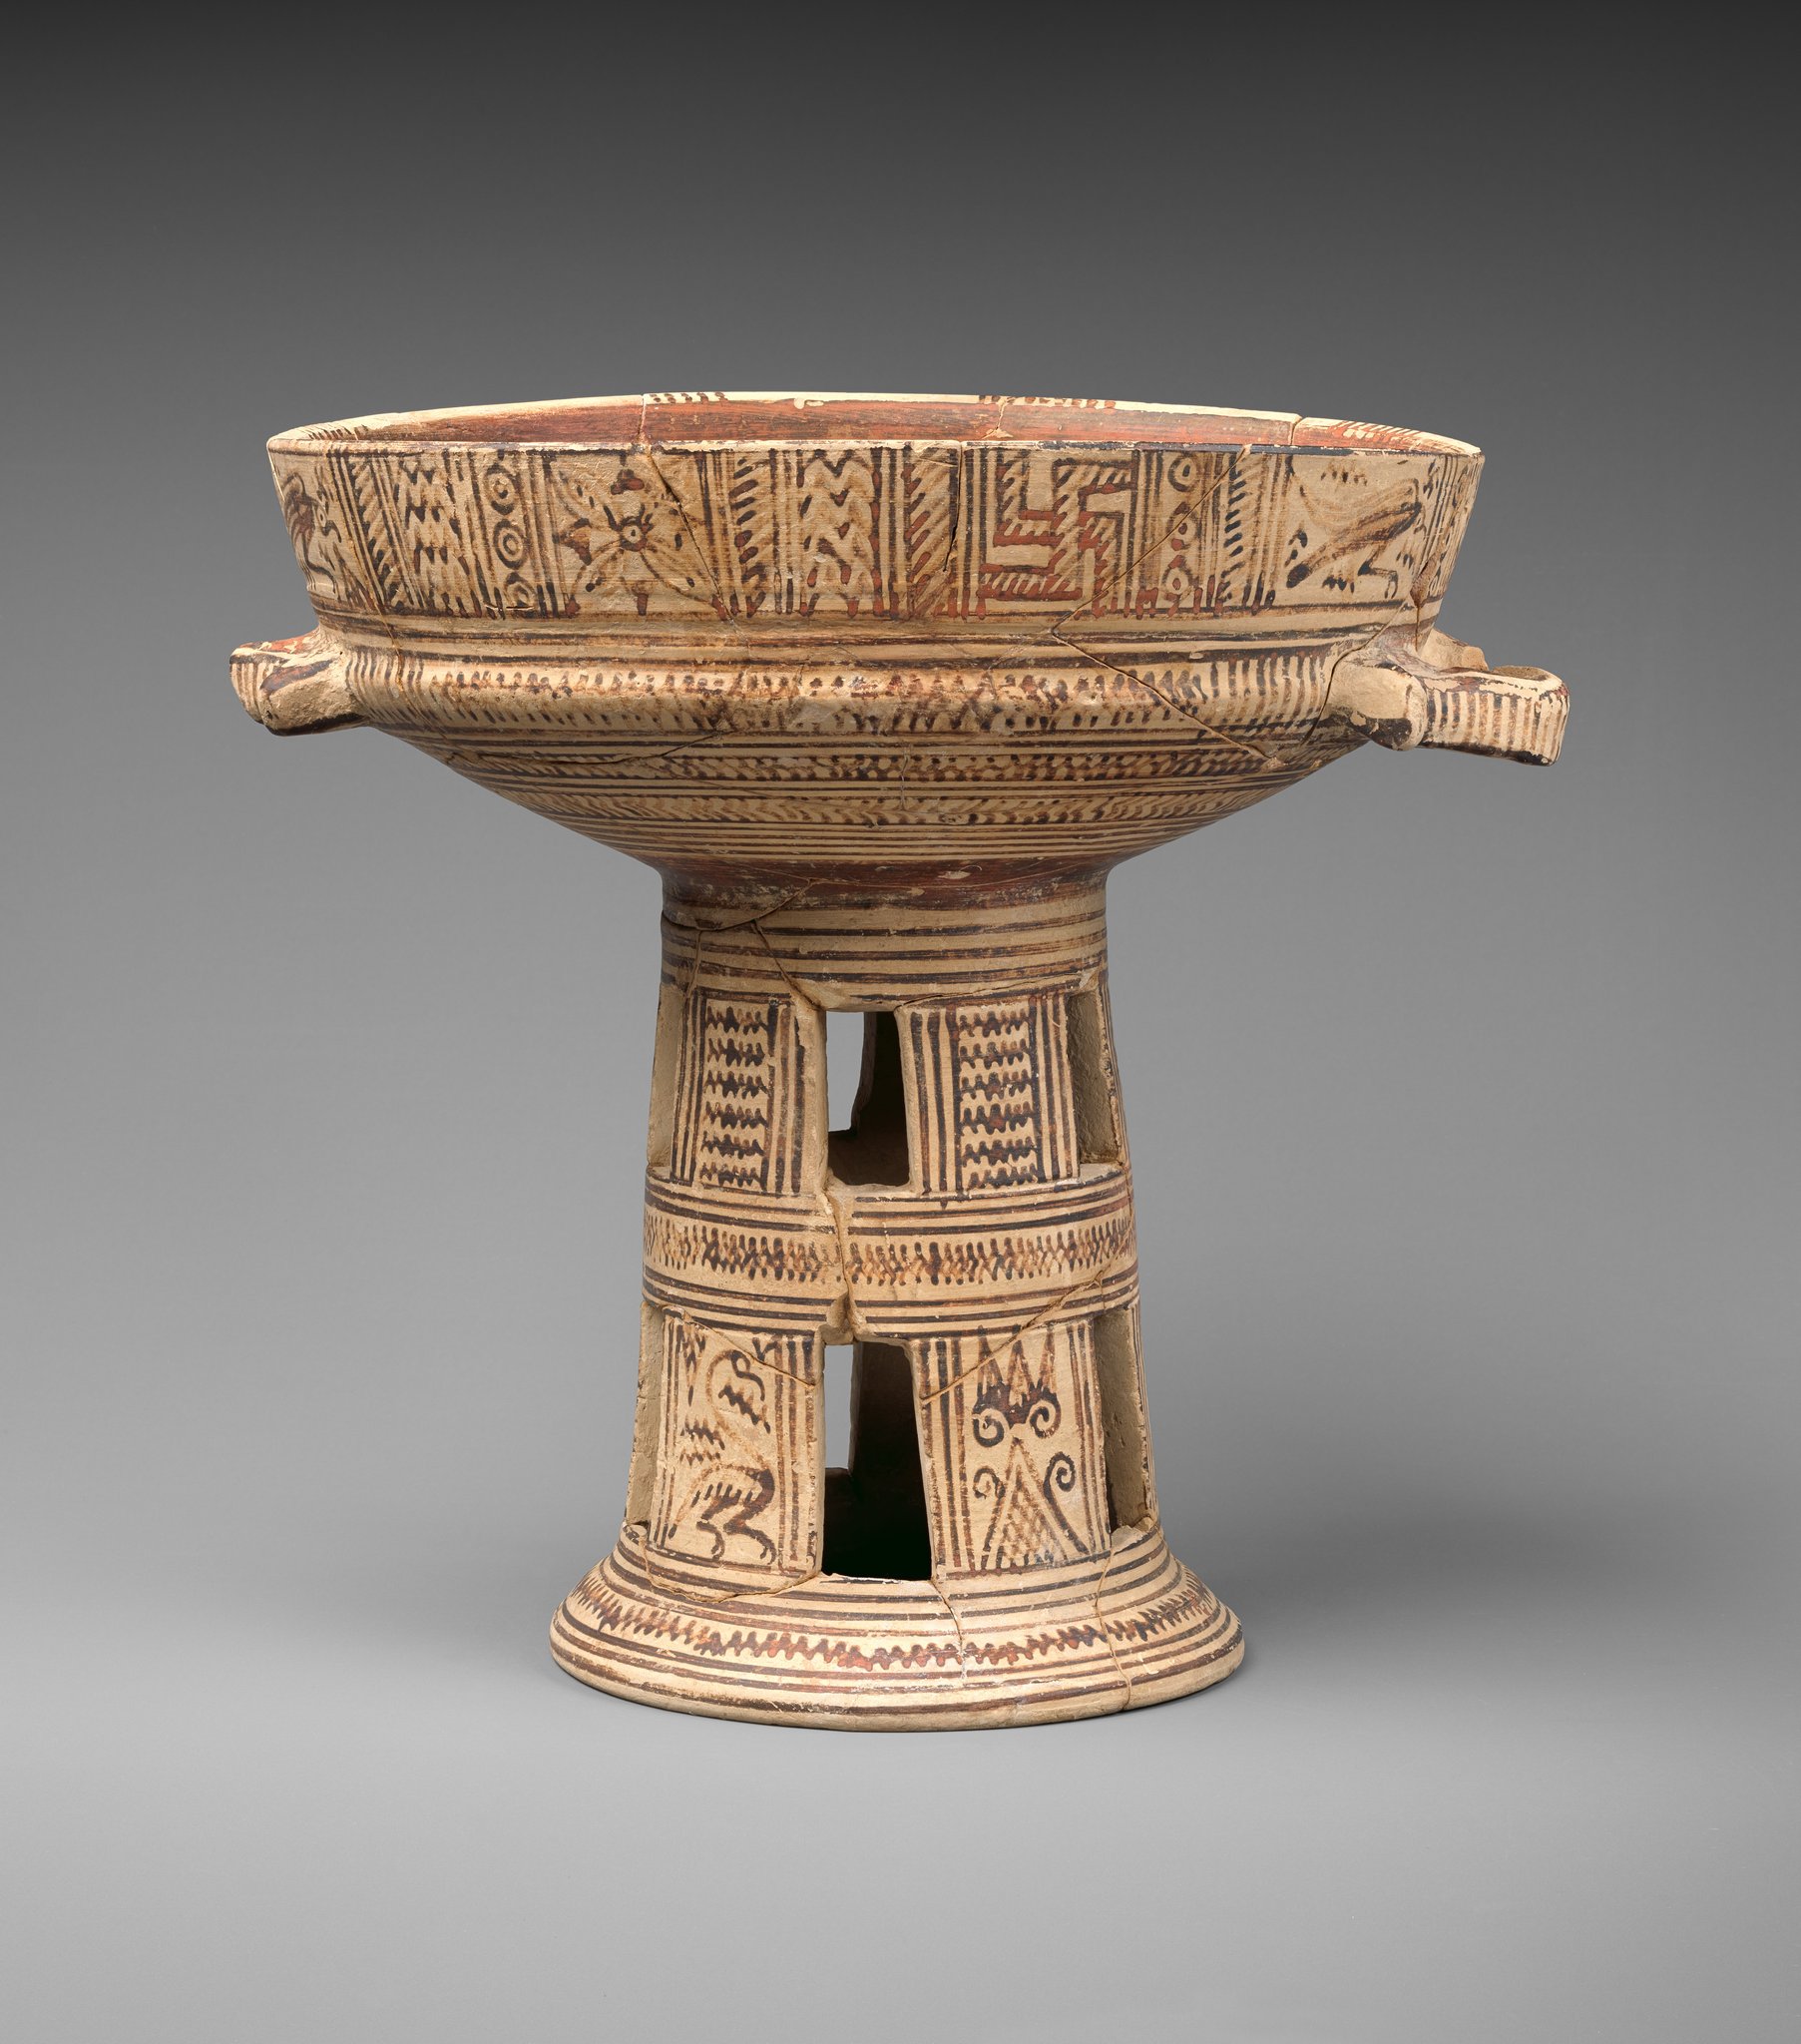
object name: bowl, fruitstand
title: Terracotta bowl on a high stand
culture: greek, attic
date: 734-701 BCE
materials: terracotta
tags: birds